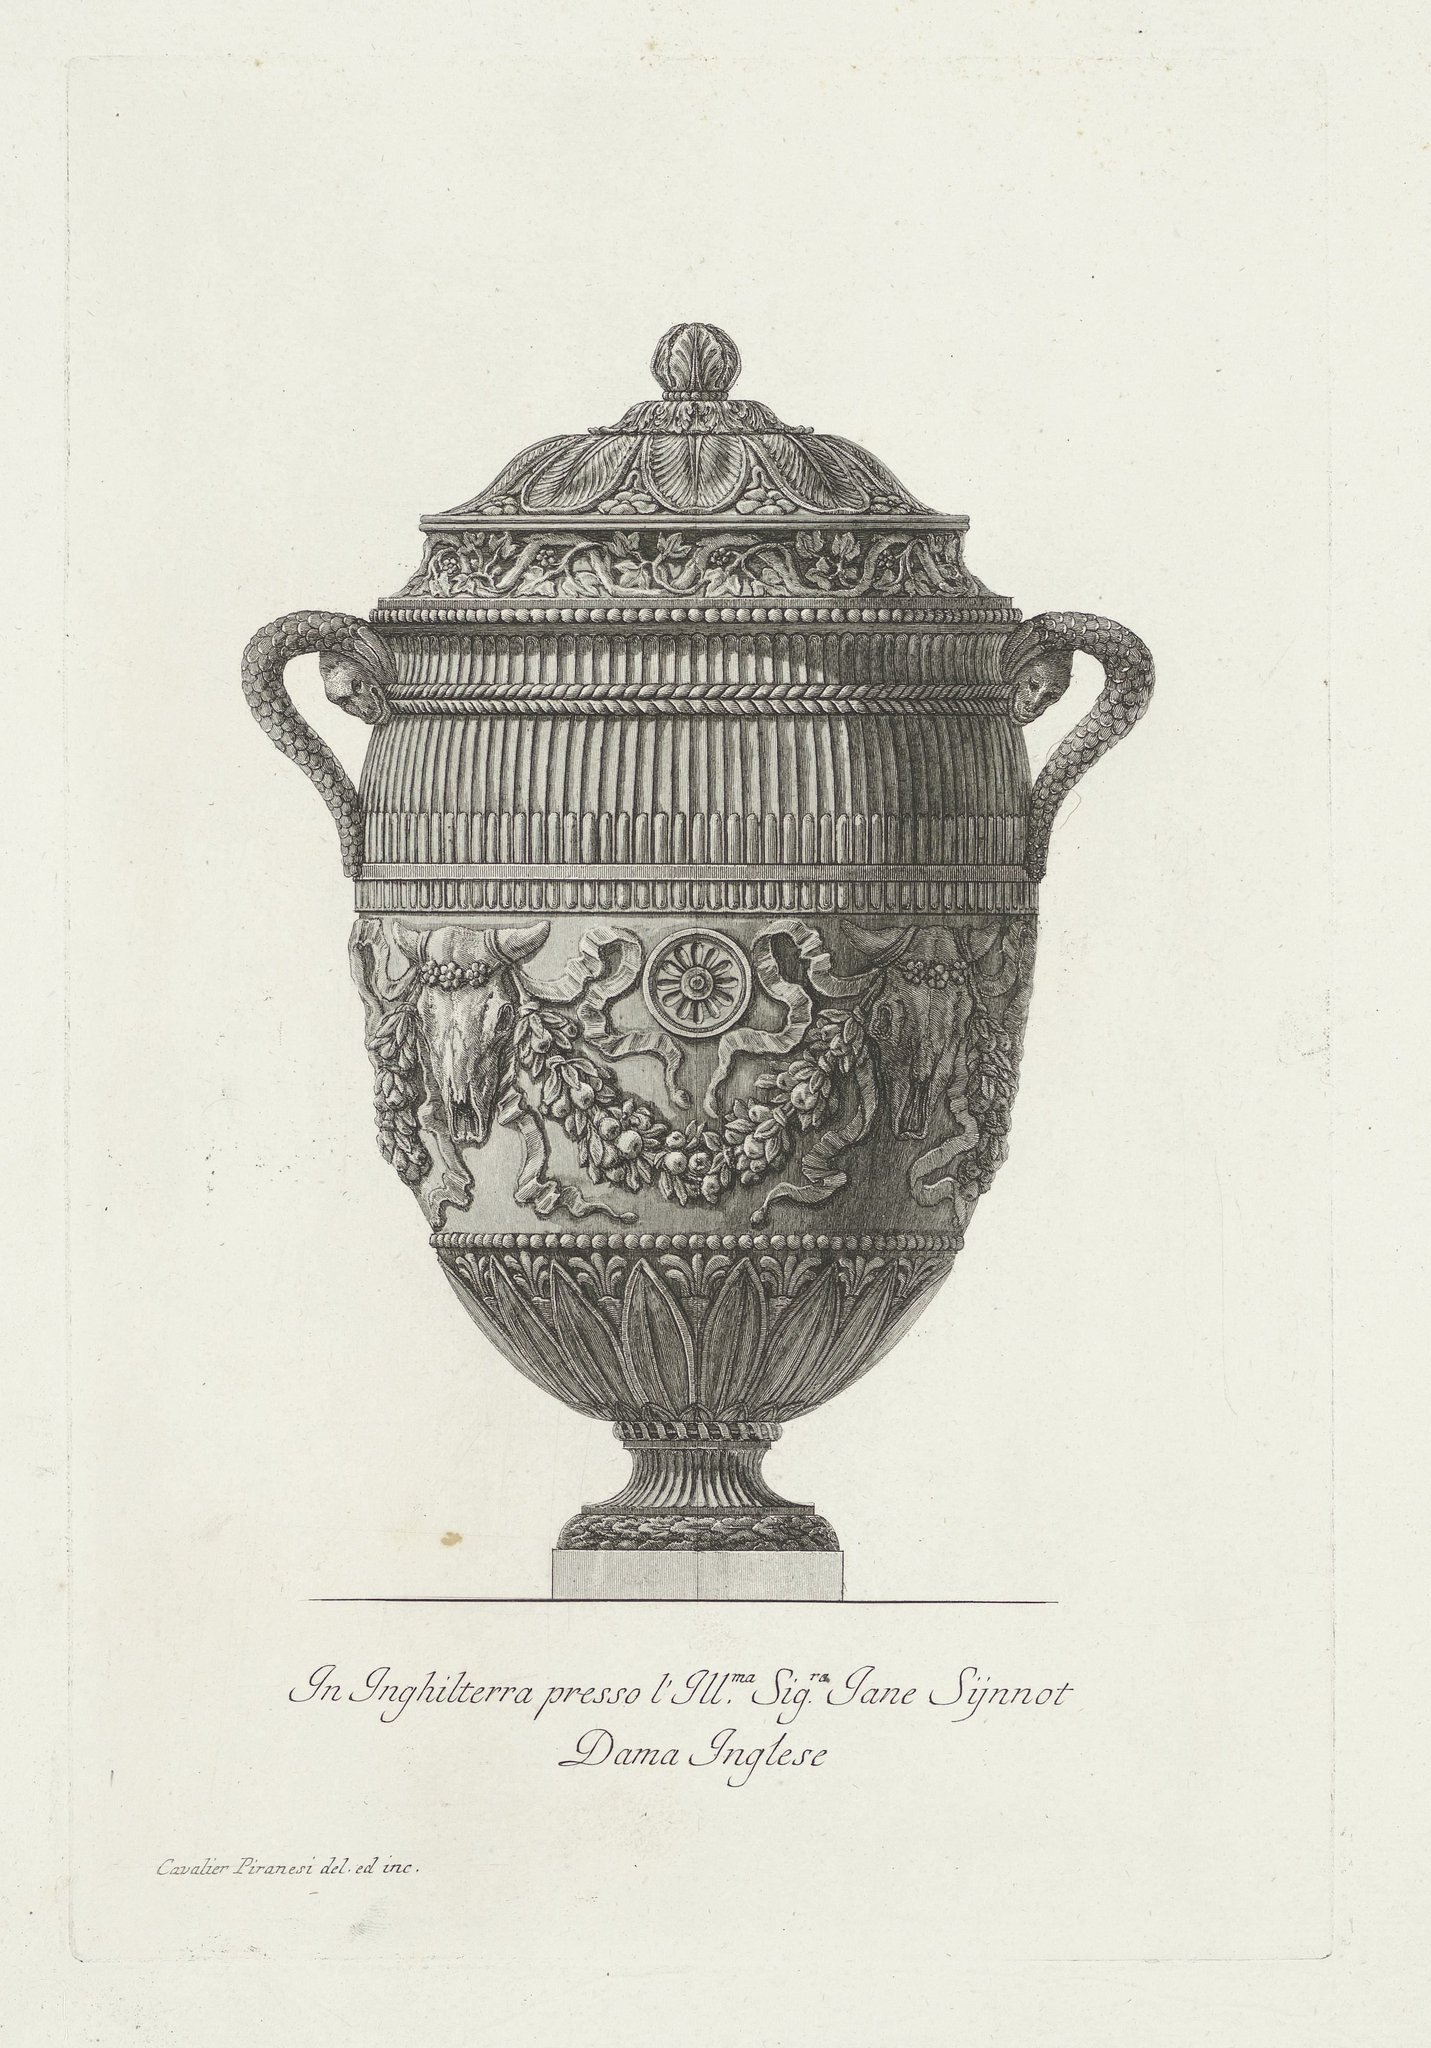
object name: print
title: Antieke vazen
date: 1778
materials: paper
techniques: etching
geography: rome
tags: bucranium ~ ornament, vase ~ ornament, ornament ~ festoon, garland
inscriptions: collector's mark: Lugt 2228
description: De 'Vasi'-reeks telt 110 prenten, verspreid over twee volumes met elk een eigen titelprent. Piranesi werd voor deze reeks geholpen door verschillende assistenten uit zijn werkplaats, waaronder zijn zoon Francesco die ook nog eens 8 platen toevoegde aan de reeks in 1779-1780.